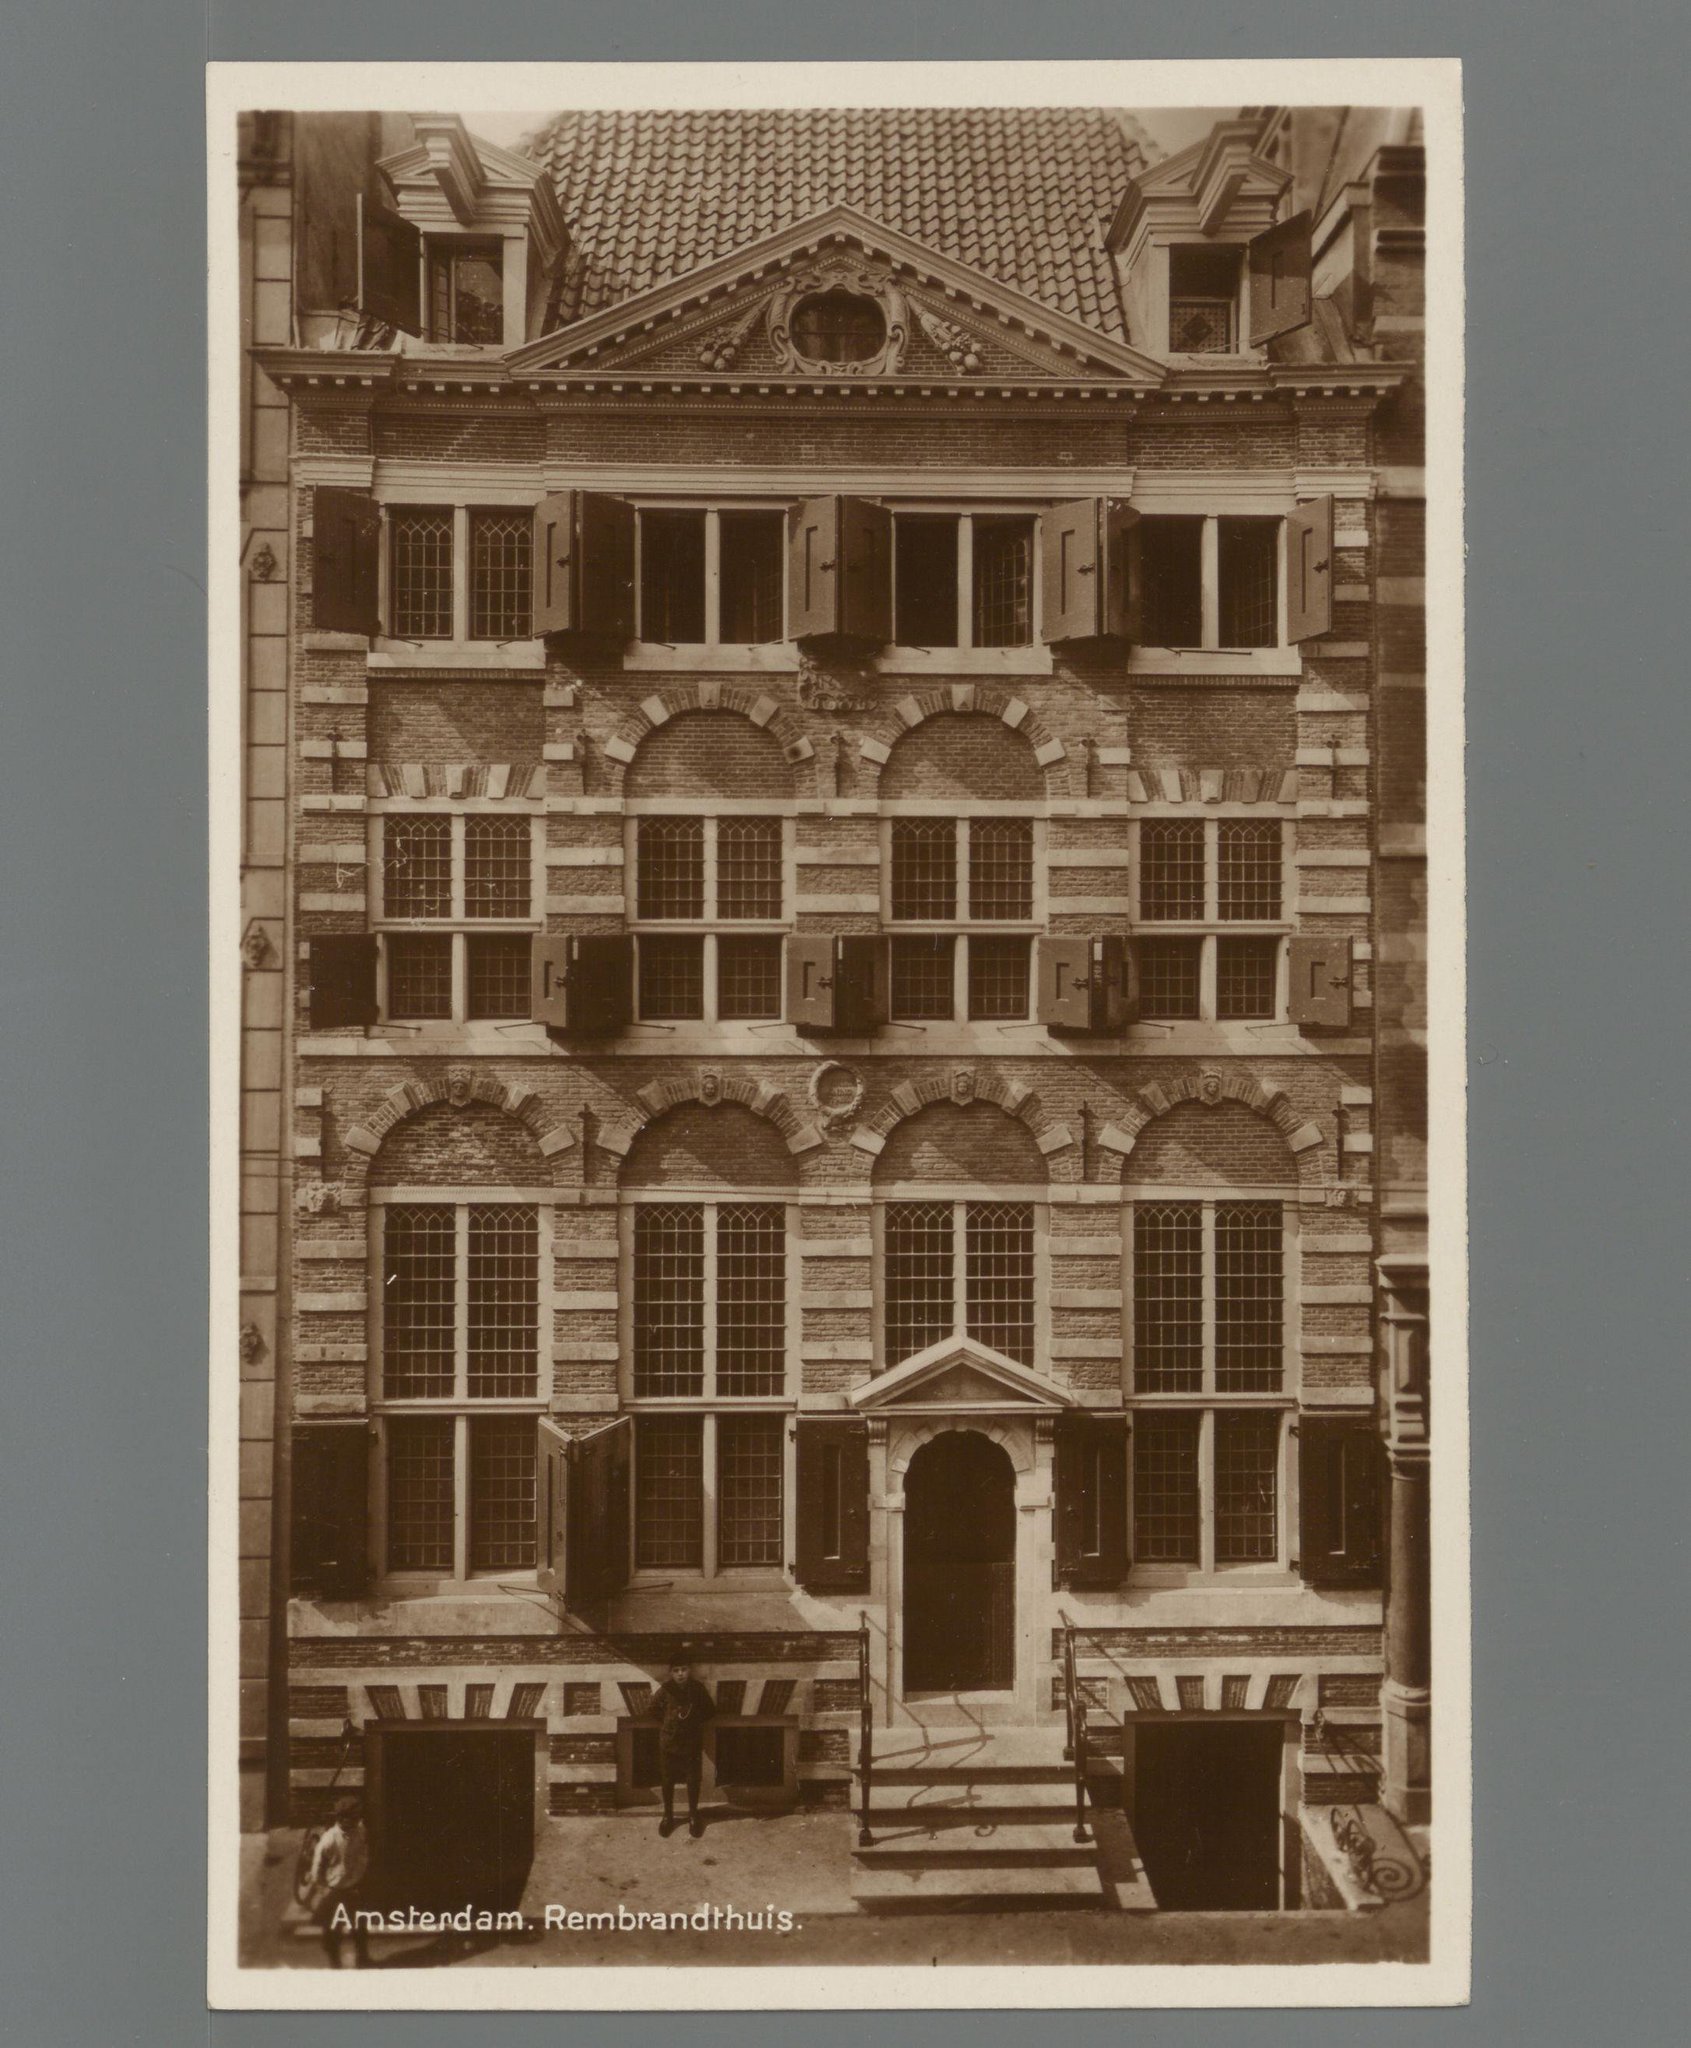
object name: ansichtkaart, prentbriefkaart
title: Amsterdam. Rembrandthuis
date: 1925-1950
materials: photographic support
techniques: photography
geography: amsterdam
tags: house combined with shop, exterior ~ representation of a building